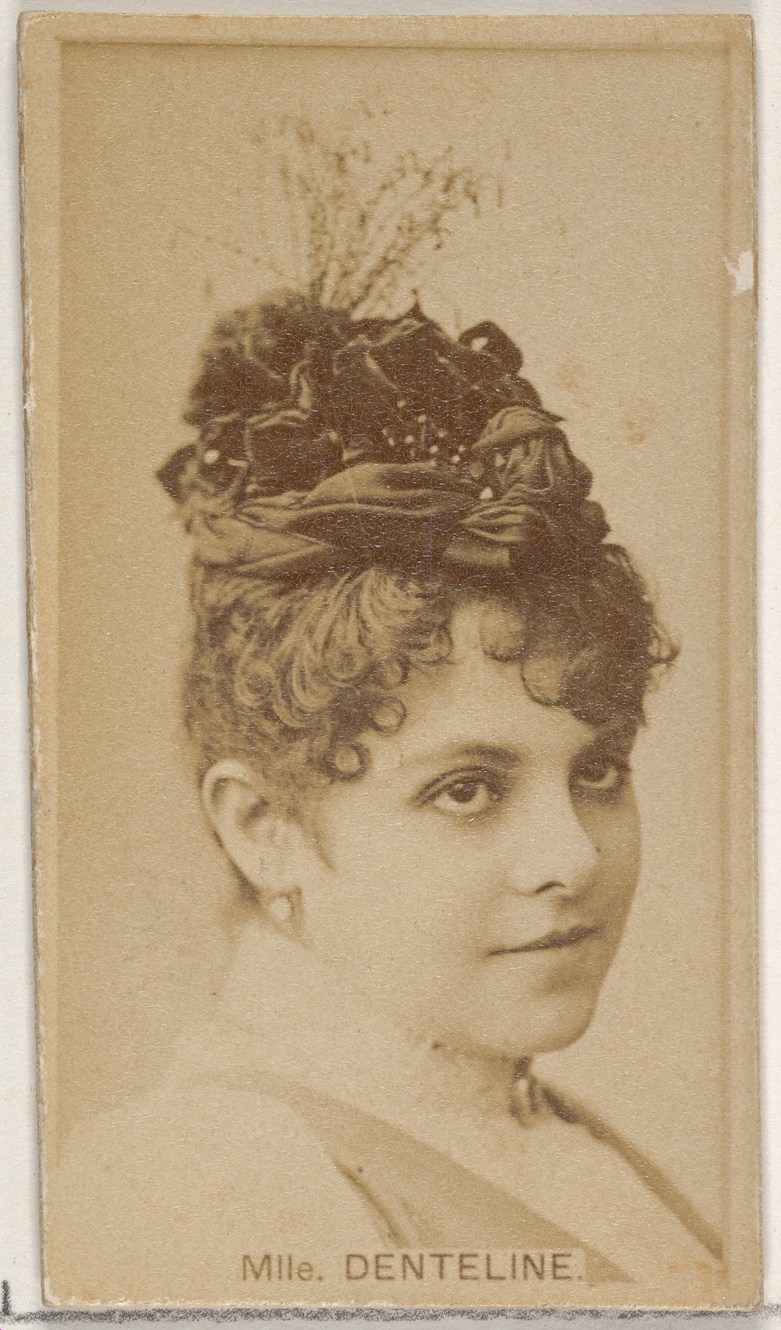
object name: photograph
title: Mlle. Denteline, from the Actors and Actresses series (N45, Type 8) for Virginia Brights Cigarettes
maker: allen & ginter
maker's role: publisher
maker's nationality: american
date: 1888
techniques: albumen silver print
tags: portraits,women,actresses